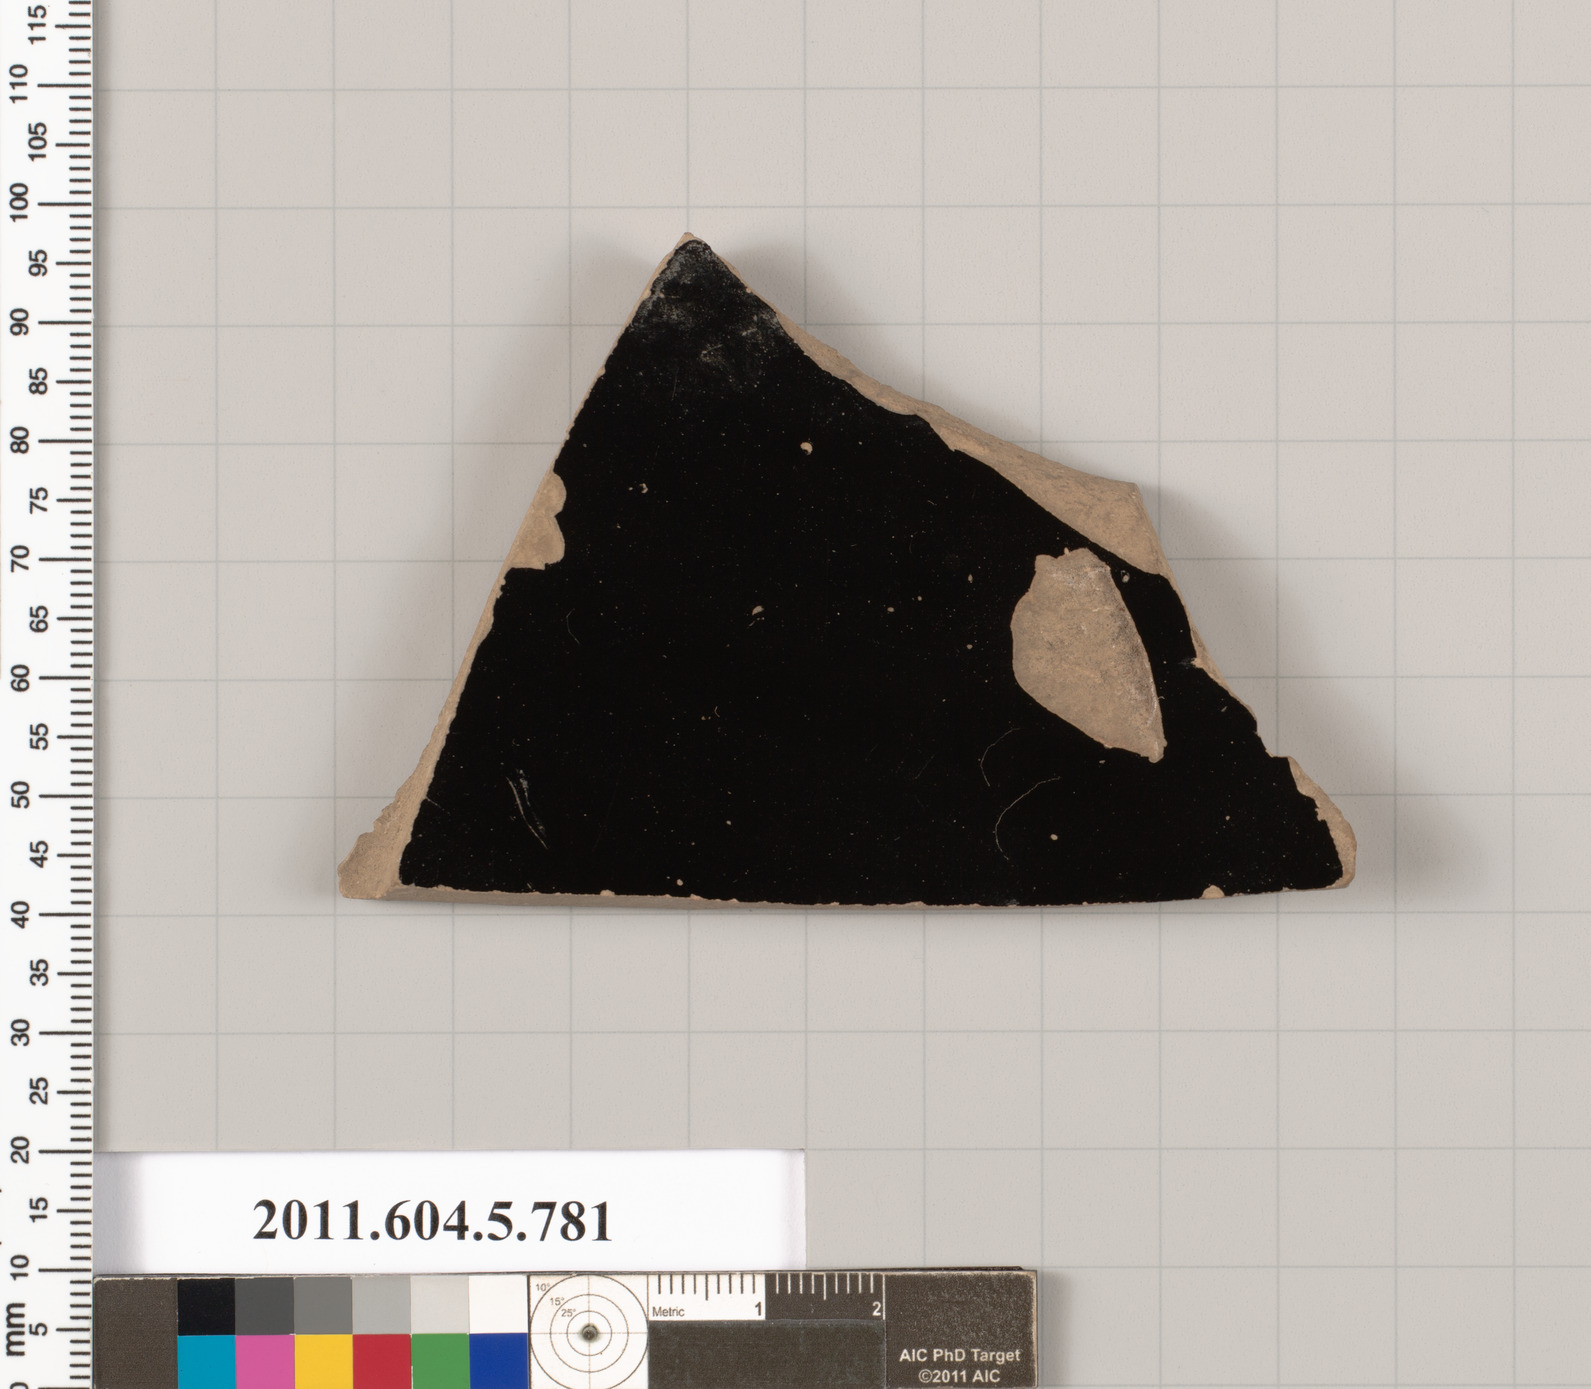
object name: kylix fragment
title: Terracotta fragment of a kylix (drinking cup)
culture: greek, attic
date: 600-401 BCE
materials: terracotta